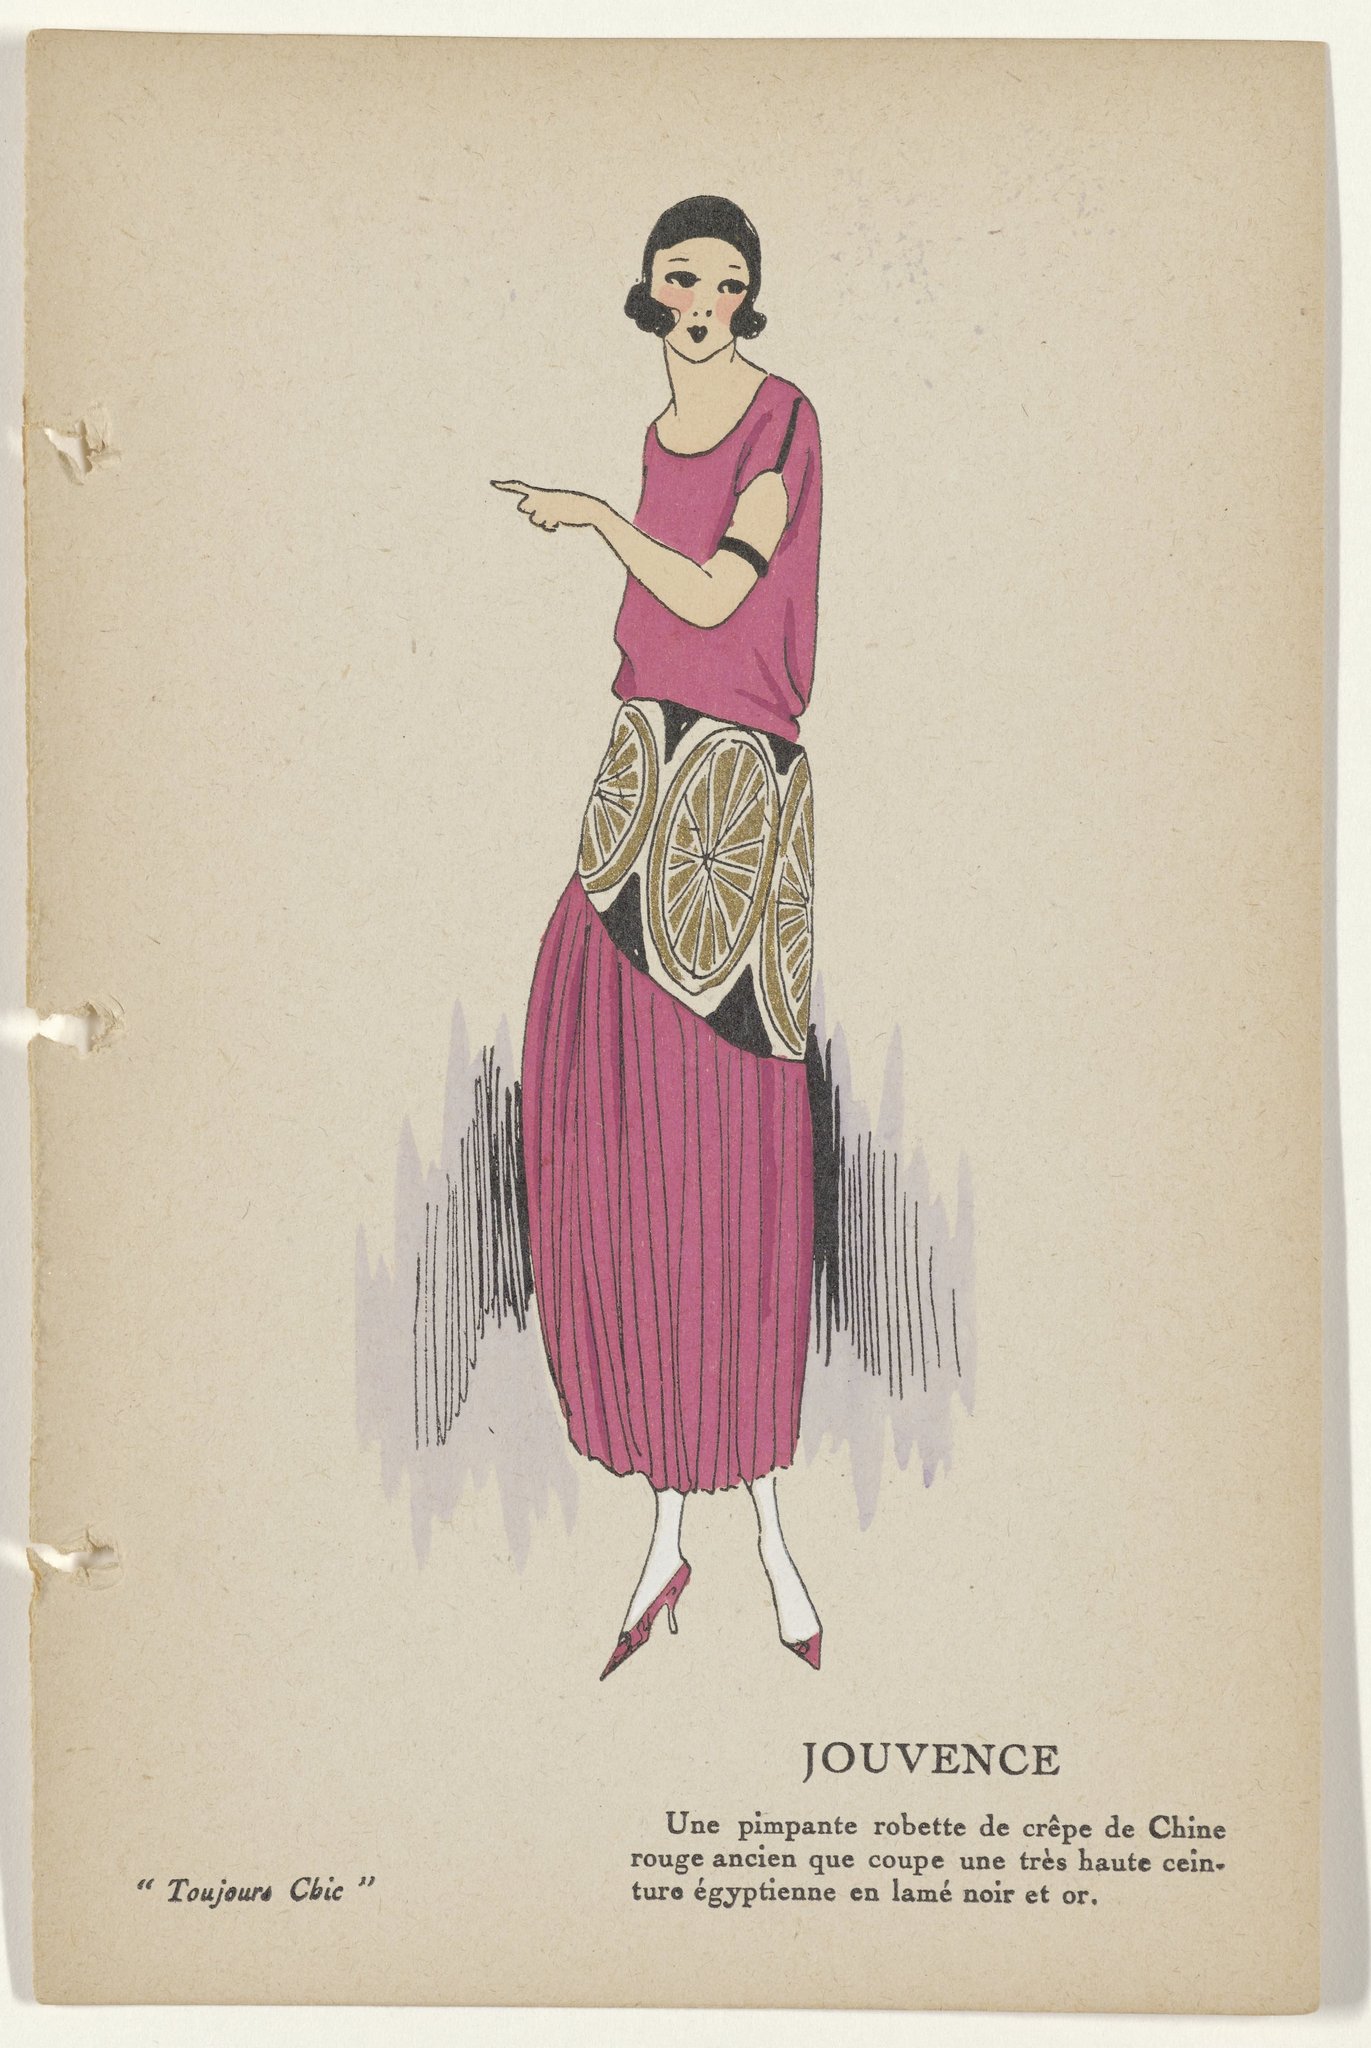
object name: fashion print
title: Toujours Chic Les Robes, Hiver 1921-1922: Jouvence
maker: g-p. joumard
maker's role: publisher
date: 1921-1922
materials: paper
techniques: letterpress printing, pochoir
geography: paris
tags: fashion plates, dress, gown (+ women's clothes)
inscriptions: date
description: Japon van rode crêpe de Chine met brede 'Egyptische' ceintuur. Prent uit Catalogus "Toujours Chic" waarin een overzicht van de wintermode 1921-1922 in 80 prentjes in pochoir techniek.